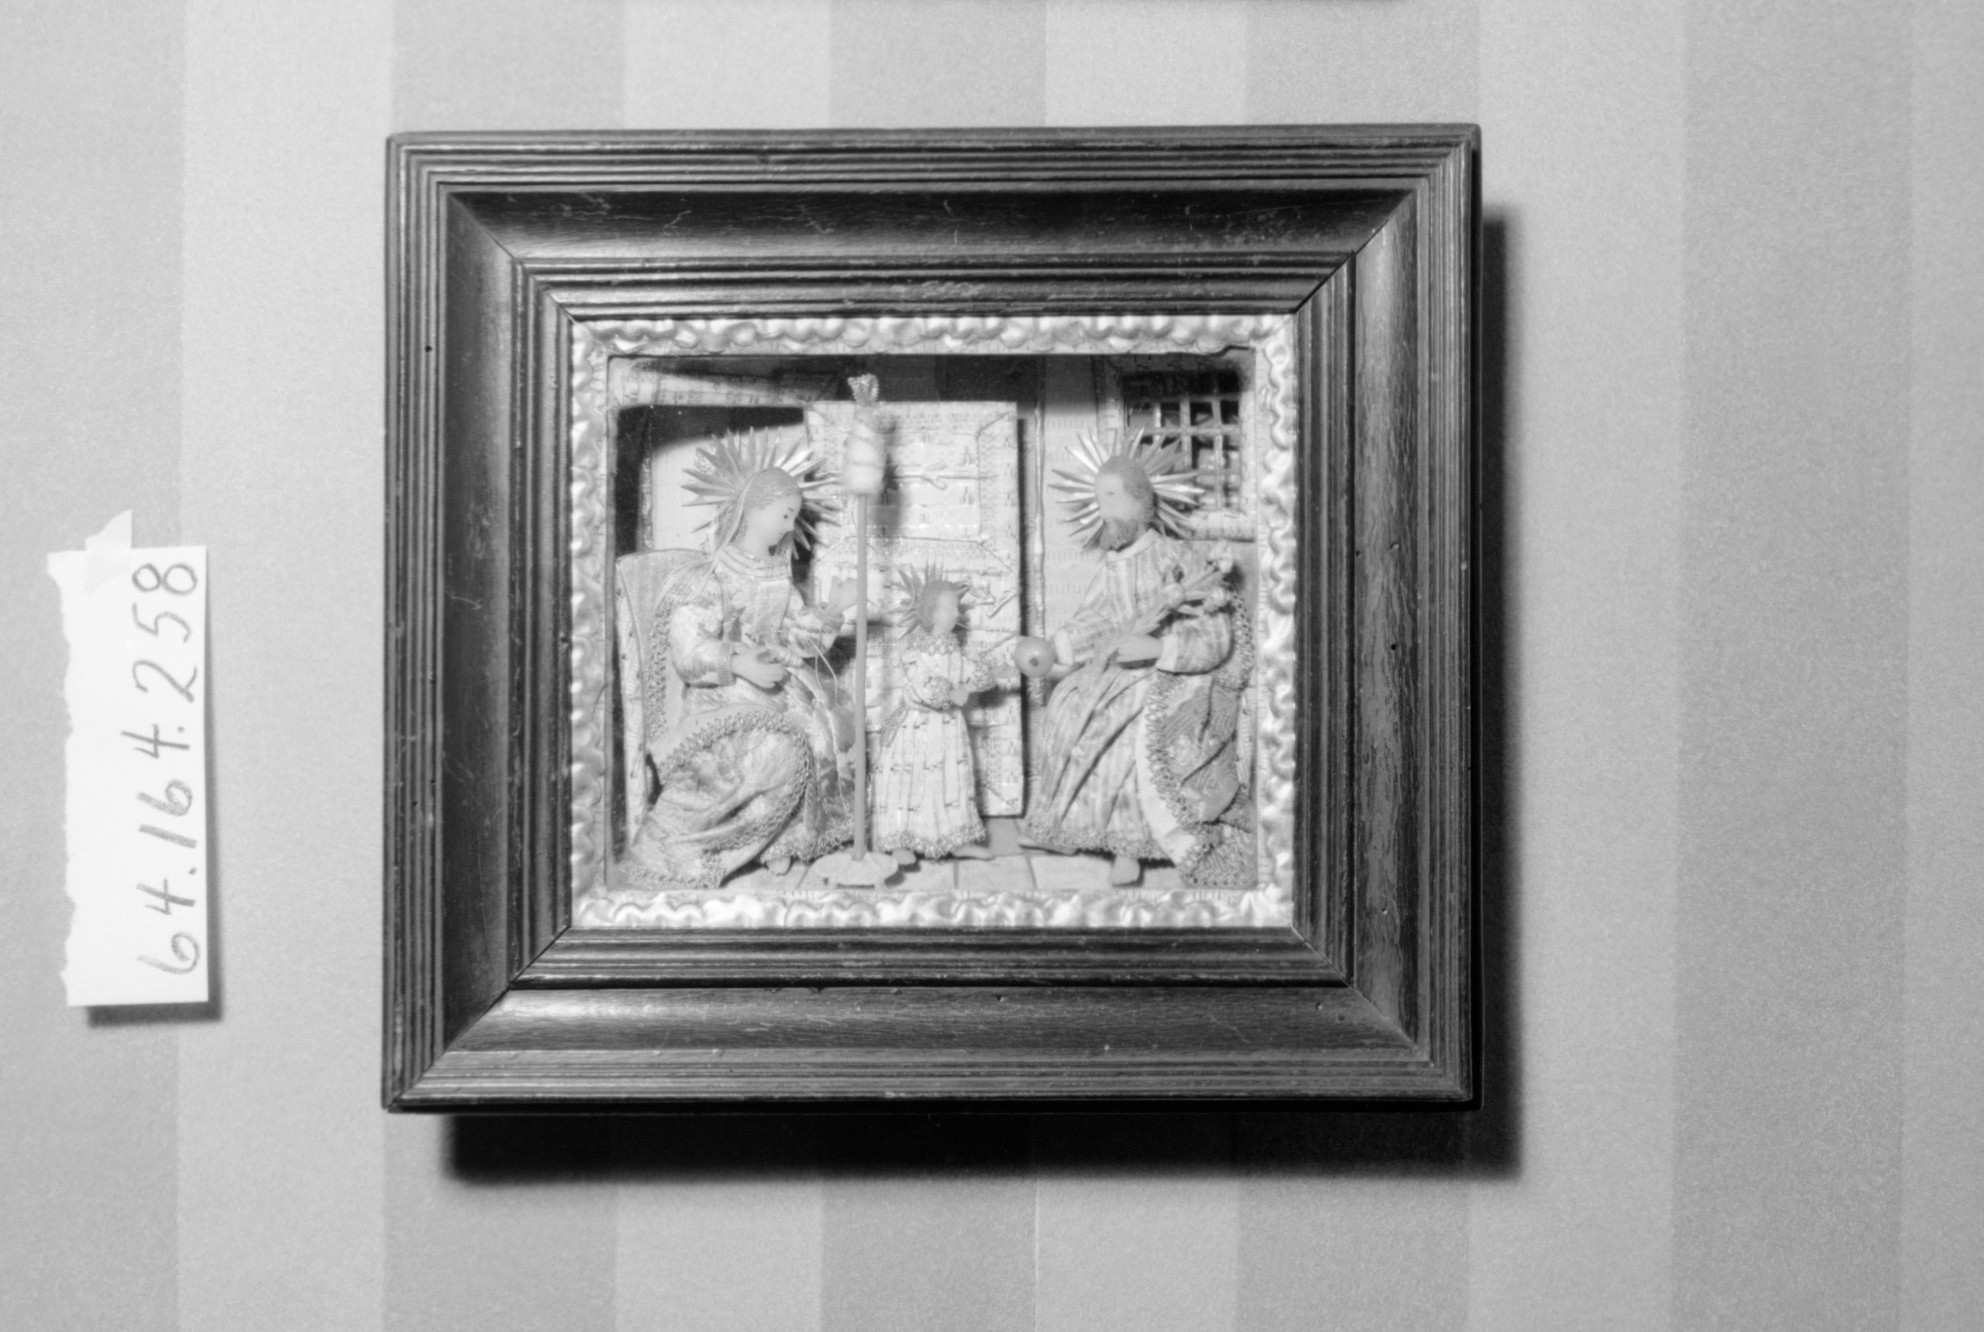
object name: sculpture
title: Childhood of Jesus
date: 1701-1800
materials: glass, gold thread, paper, textile, silk, wax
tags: saint joseph,virgin mary,jesus